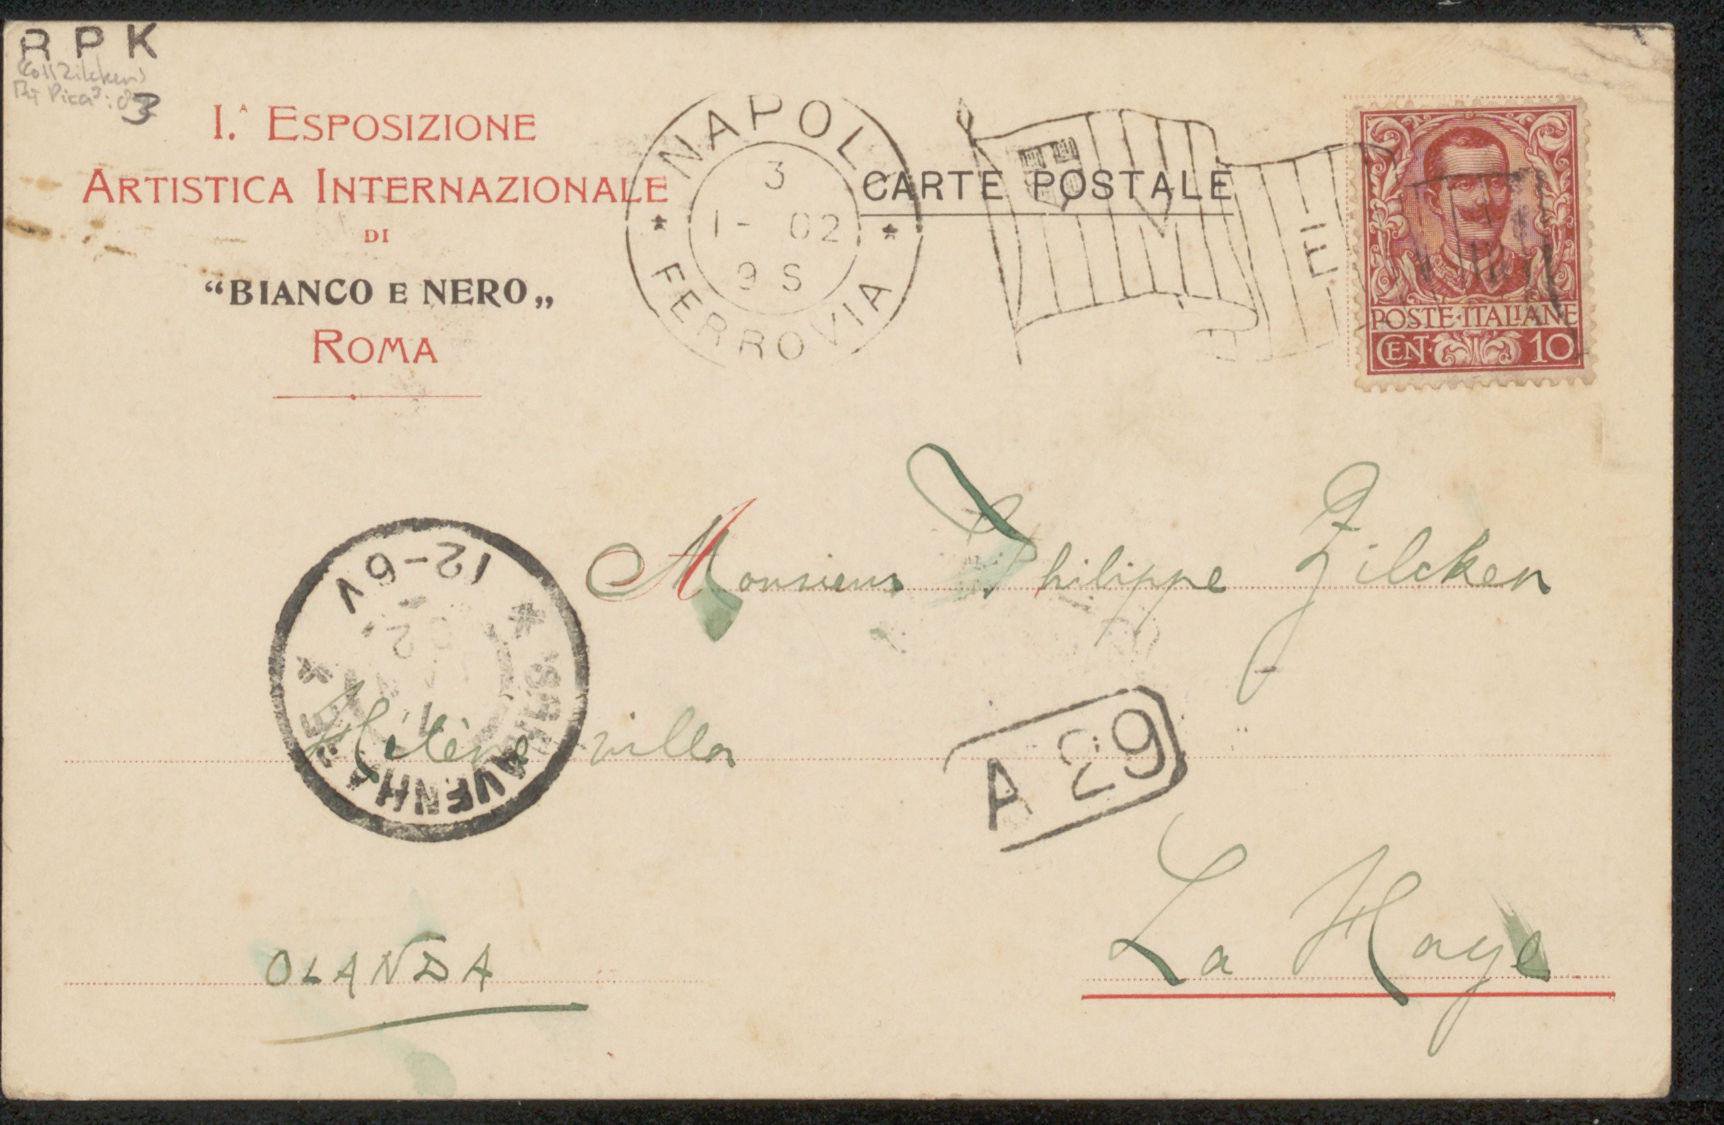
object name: postcard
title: Briefkaart aan Philip Zilcken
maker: vittorio pica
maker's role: criticus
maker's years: 1864-1930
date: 1902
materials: cardboard, ink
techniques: pen, writing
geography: naples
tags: painter, matthijs maris, willem maris, jacob maris, the hague, print maker, draughtsman, carel nicolaas storm van 's-gravesande, amsterdam, marius bauer, philip zilcken, the graphic arts, exhibition ~ art, money, venice, rome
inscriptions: collector's mark: ‘RPK’